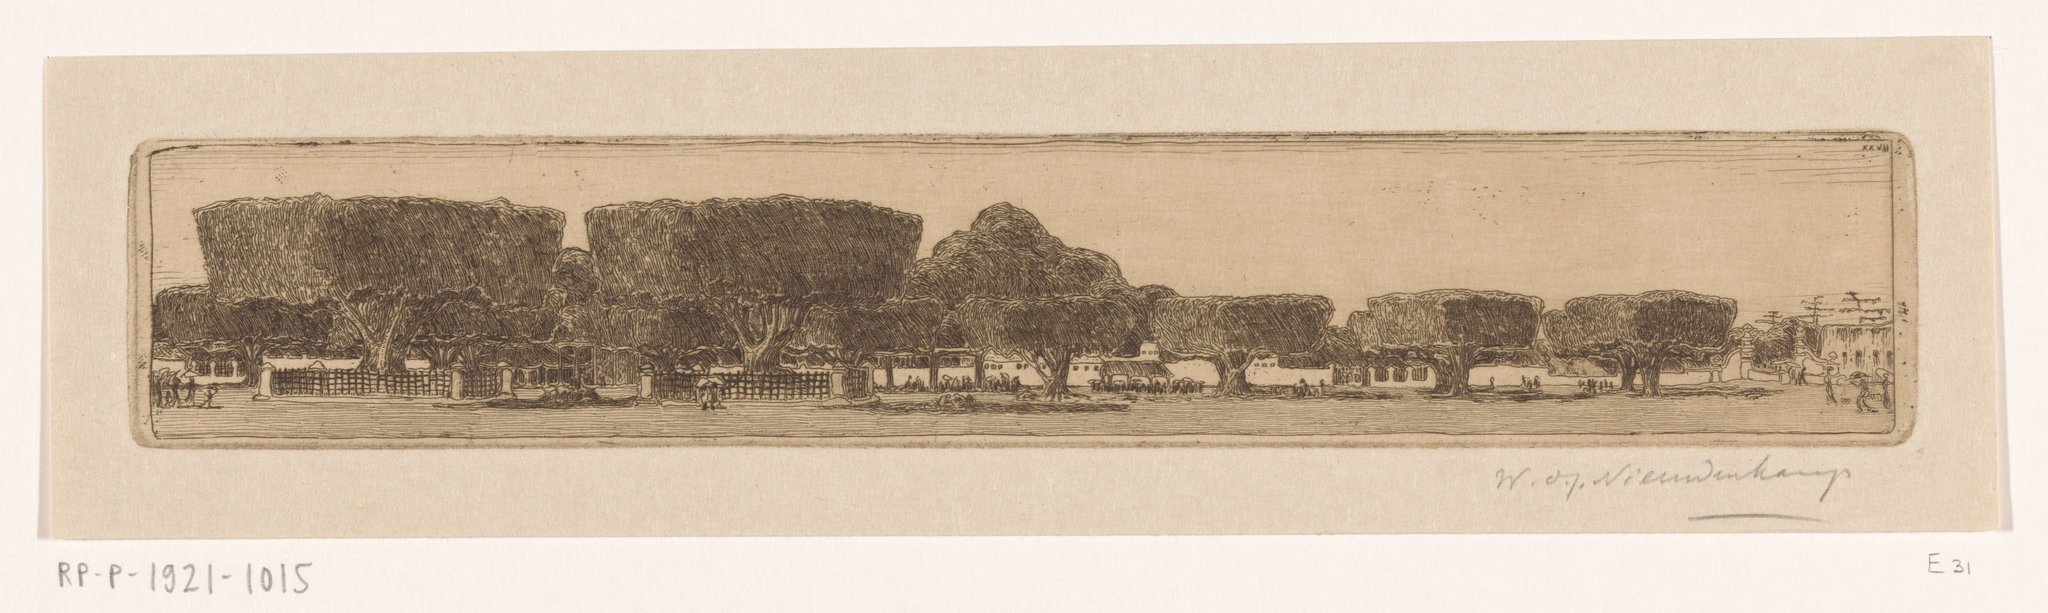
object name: print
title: Waringinbomen in de tuin van het paleis van de sultan in Jogyakarta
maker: wijnand otto jan nieuwenkamp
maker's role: draughtsman, print maker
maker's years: 1874-1950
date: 1898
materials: paper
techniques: etching, intaglio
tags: trees, palace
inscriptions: collector's mark: Lugt 2233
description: Waringinbomen, ook wel treurvijgen genoemd, in de tuin van Kraton Ngayogyakarta Hadiningrat, het paleis van de sultan in Jogyakarta op Java.